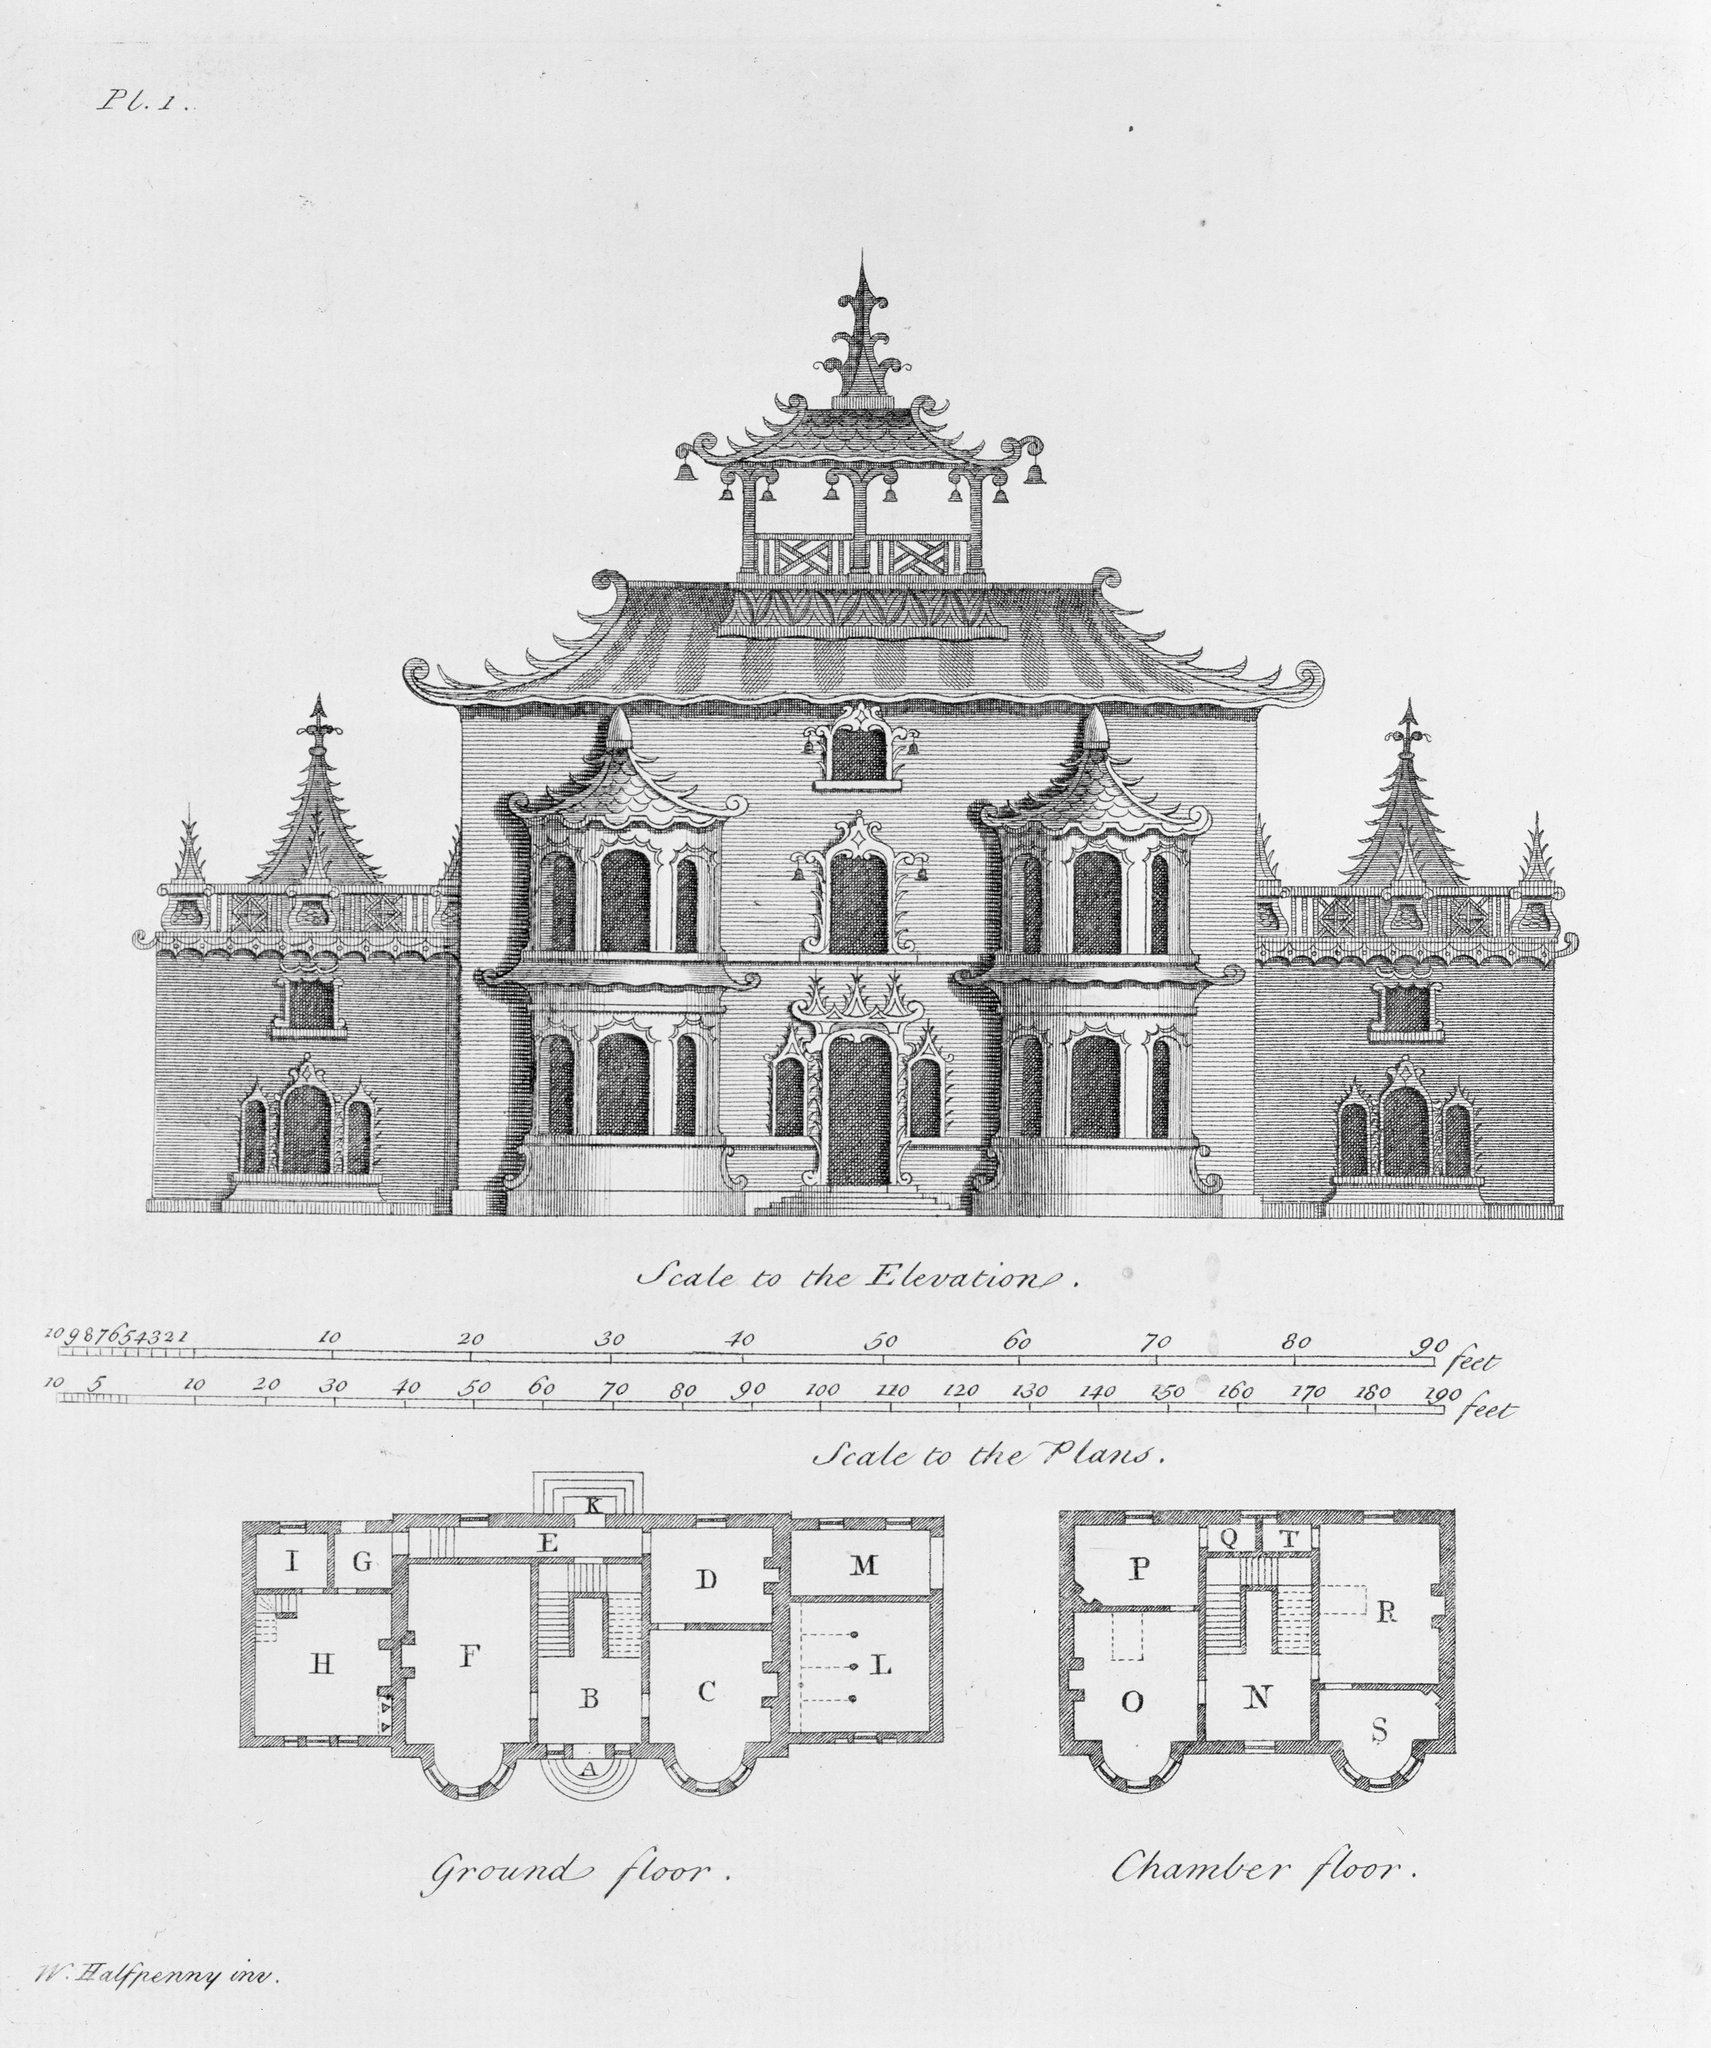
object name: book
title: The Chinese and Gothic Architecture... Being Twenty New Plans and Elevations, On Twelve Copper-Plates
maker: william halfpenny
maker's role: author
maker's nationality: british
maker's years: 1720-1755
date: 1752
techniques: engraving, etching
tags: buildings